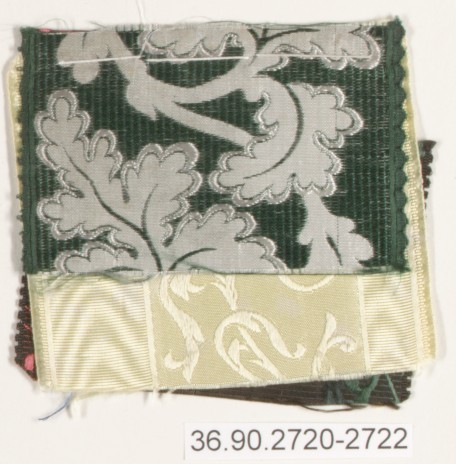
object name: ribbon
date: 1801-1900